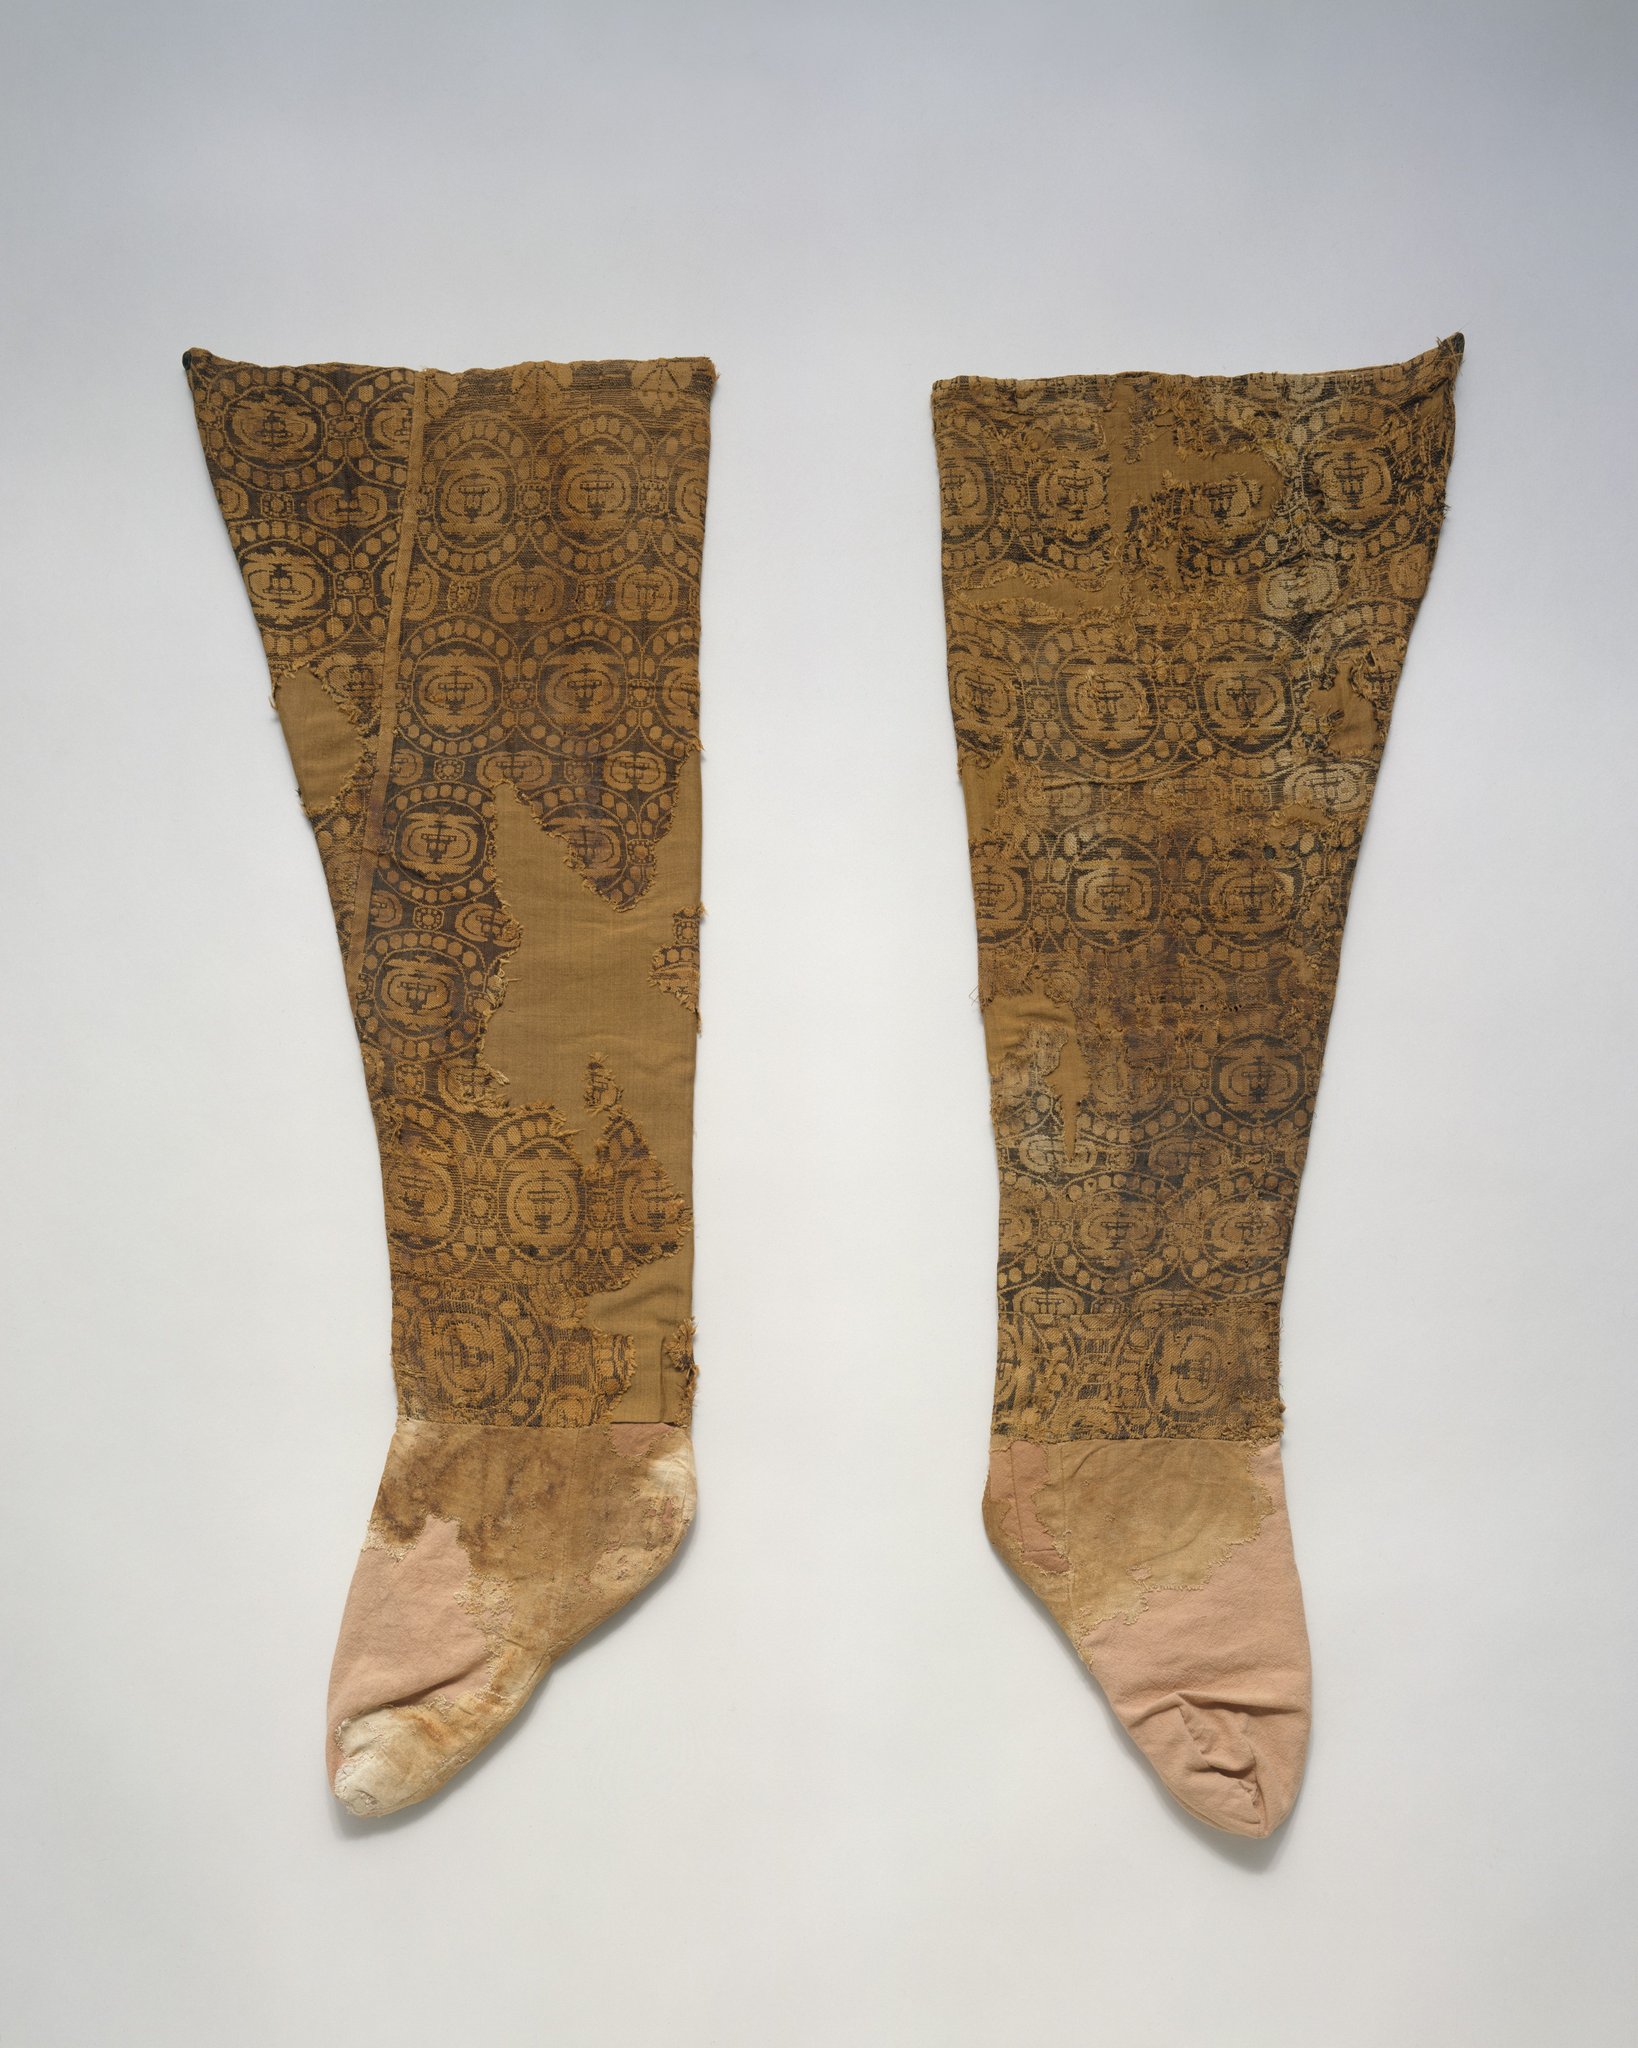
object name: textile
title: Leggings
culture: alanic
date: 601-900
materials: linen, silk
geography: caucasus